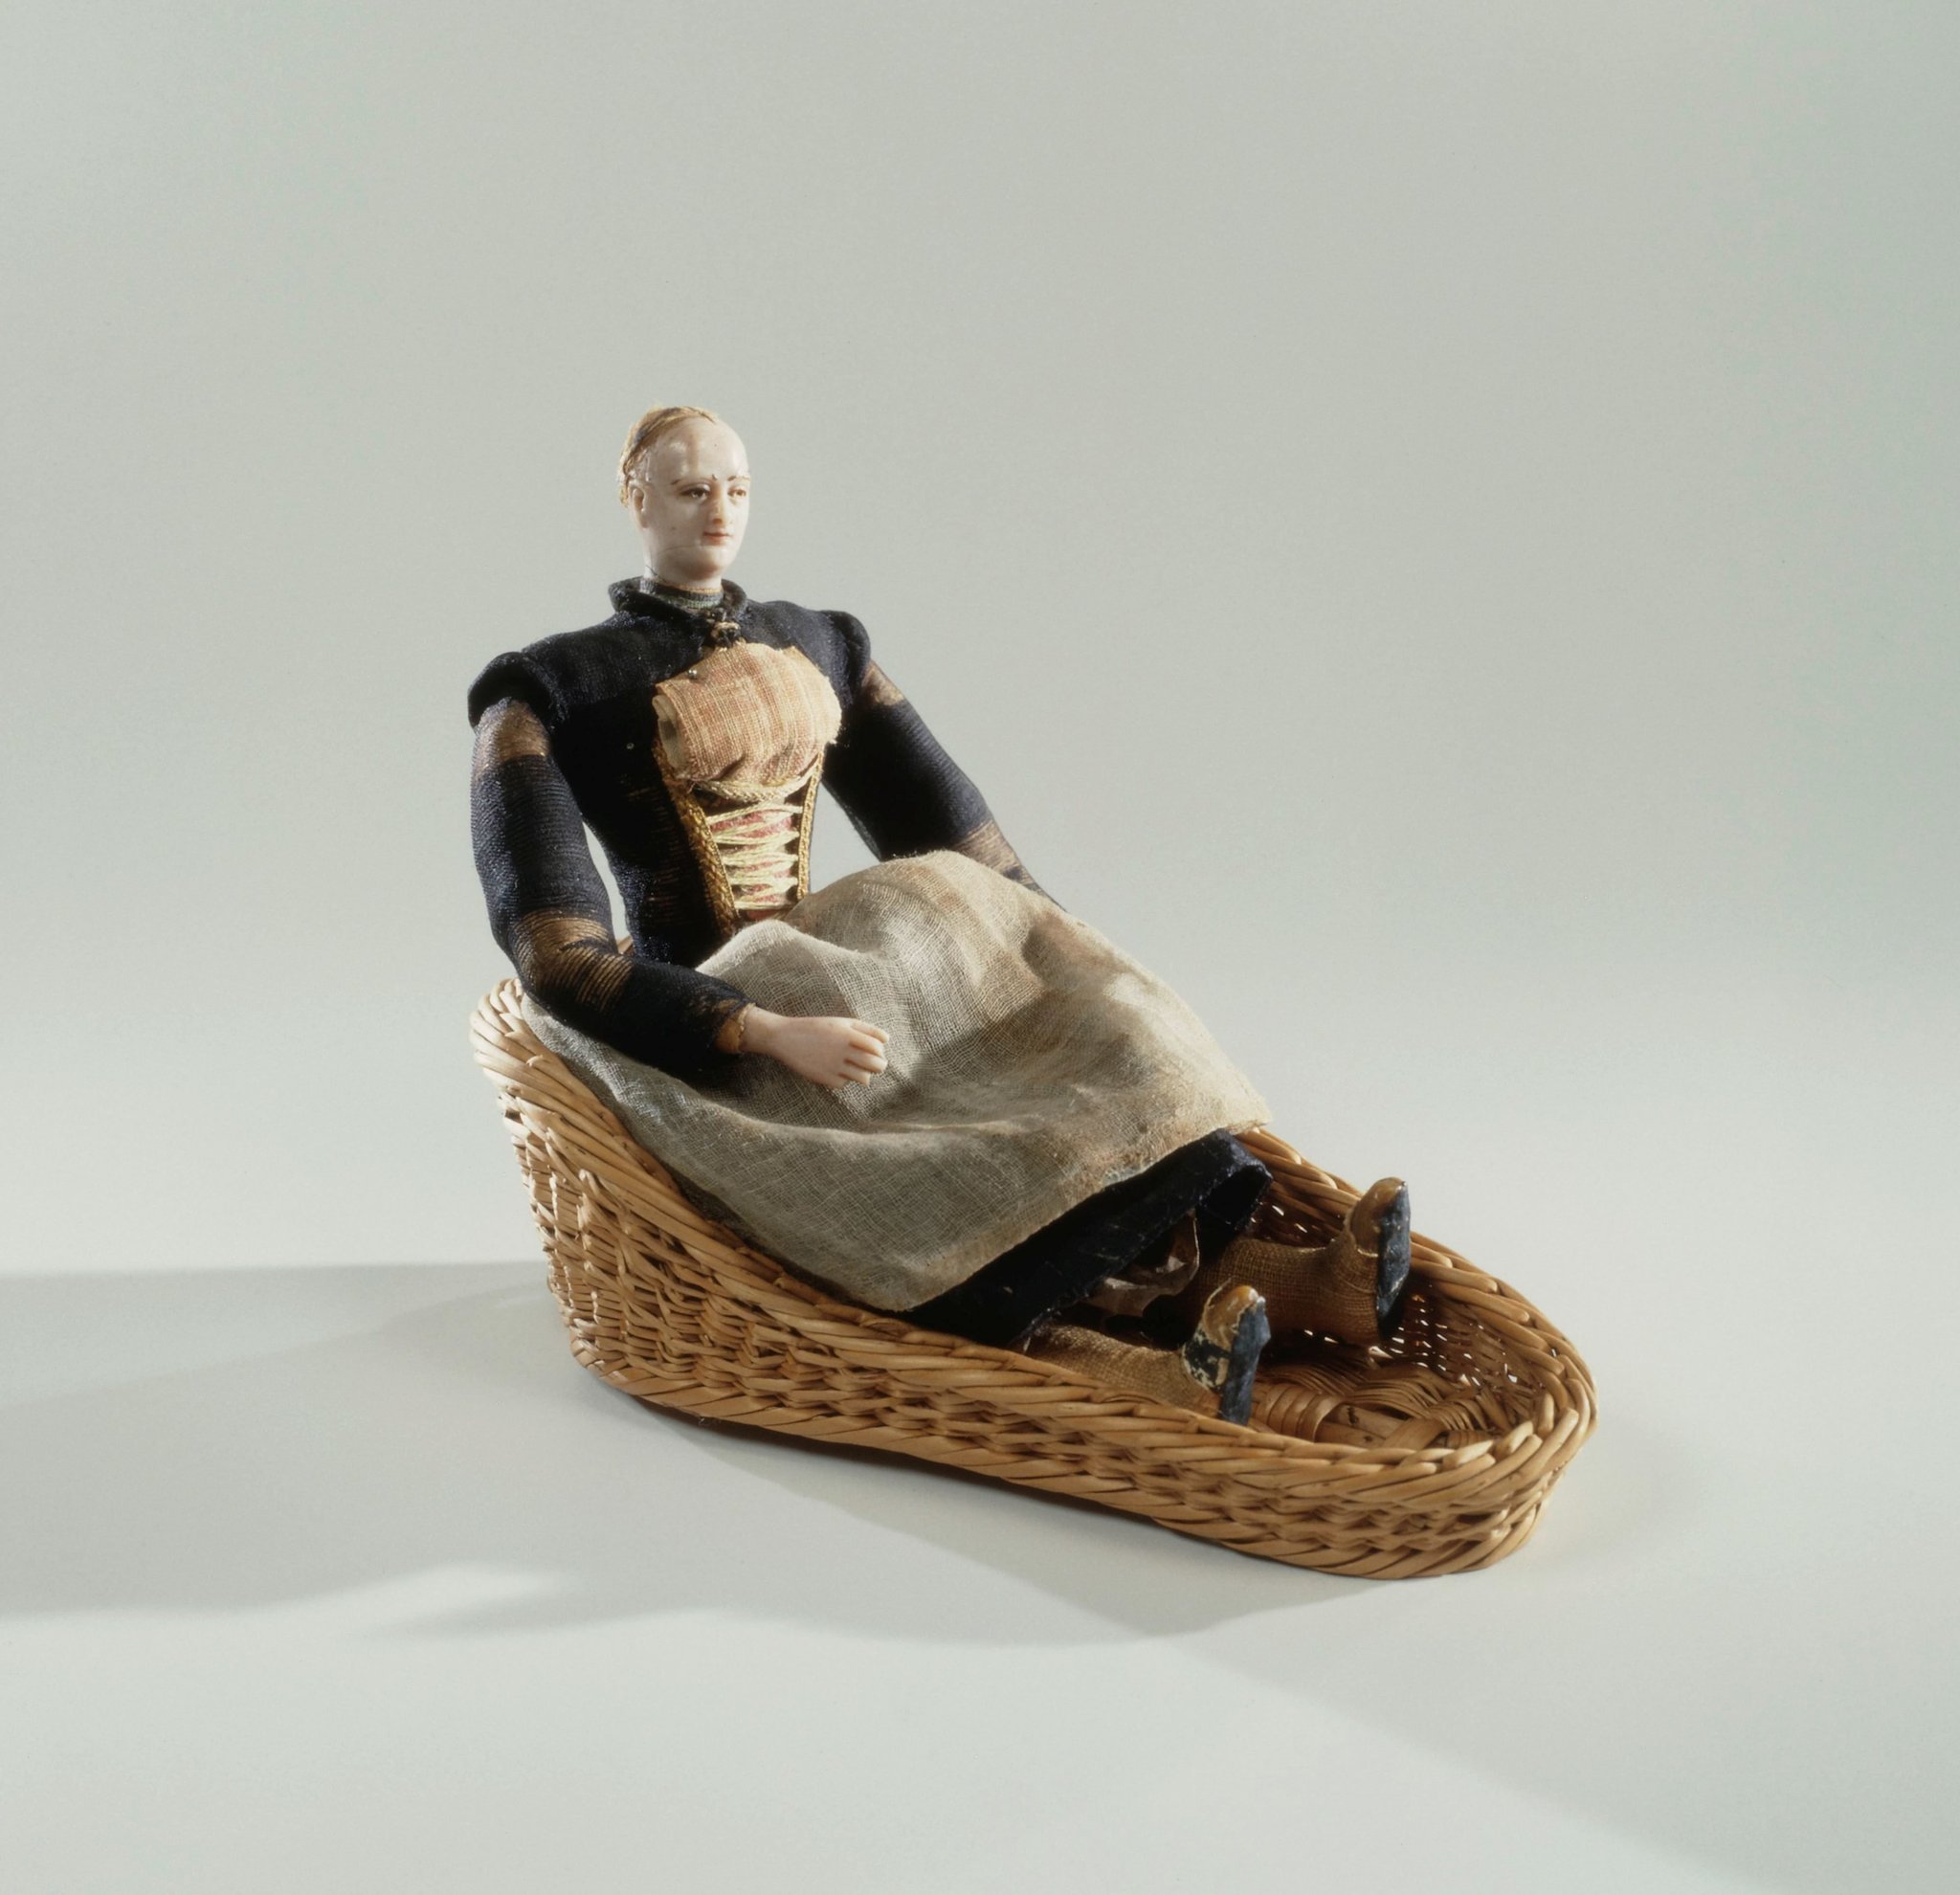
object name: doll's clothing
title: Pop, een min, in bakermat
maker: Anonymous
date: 1600-1699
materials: textile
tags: nursing-chair (dutch: 'bakermat')